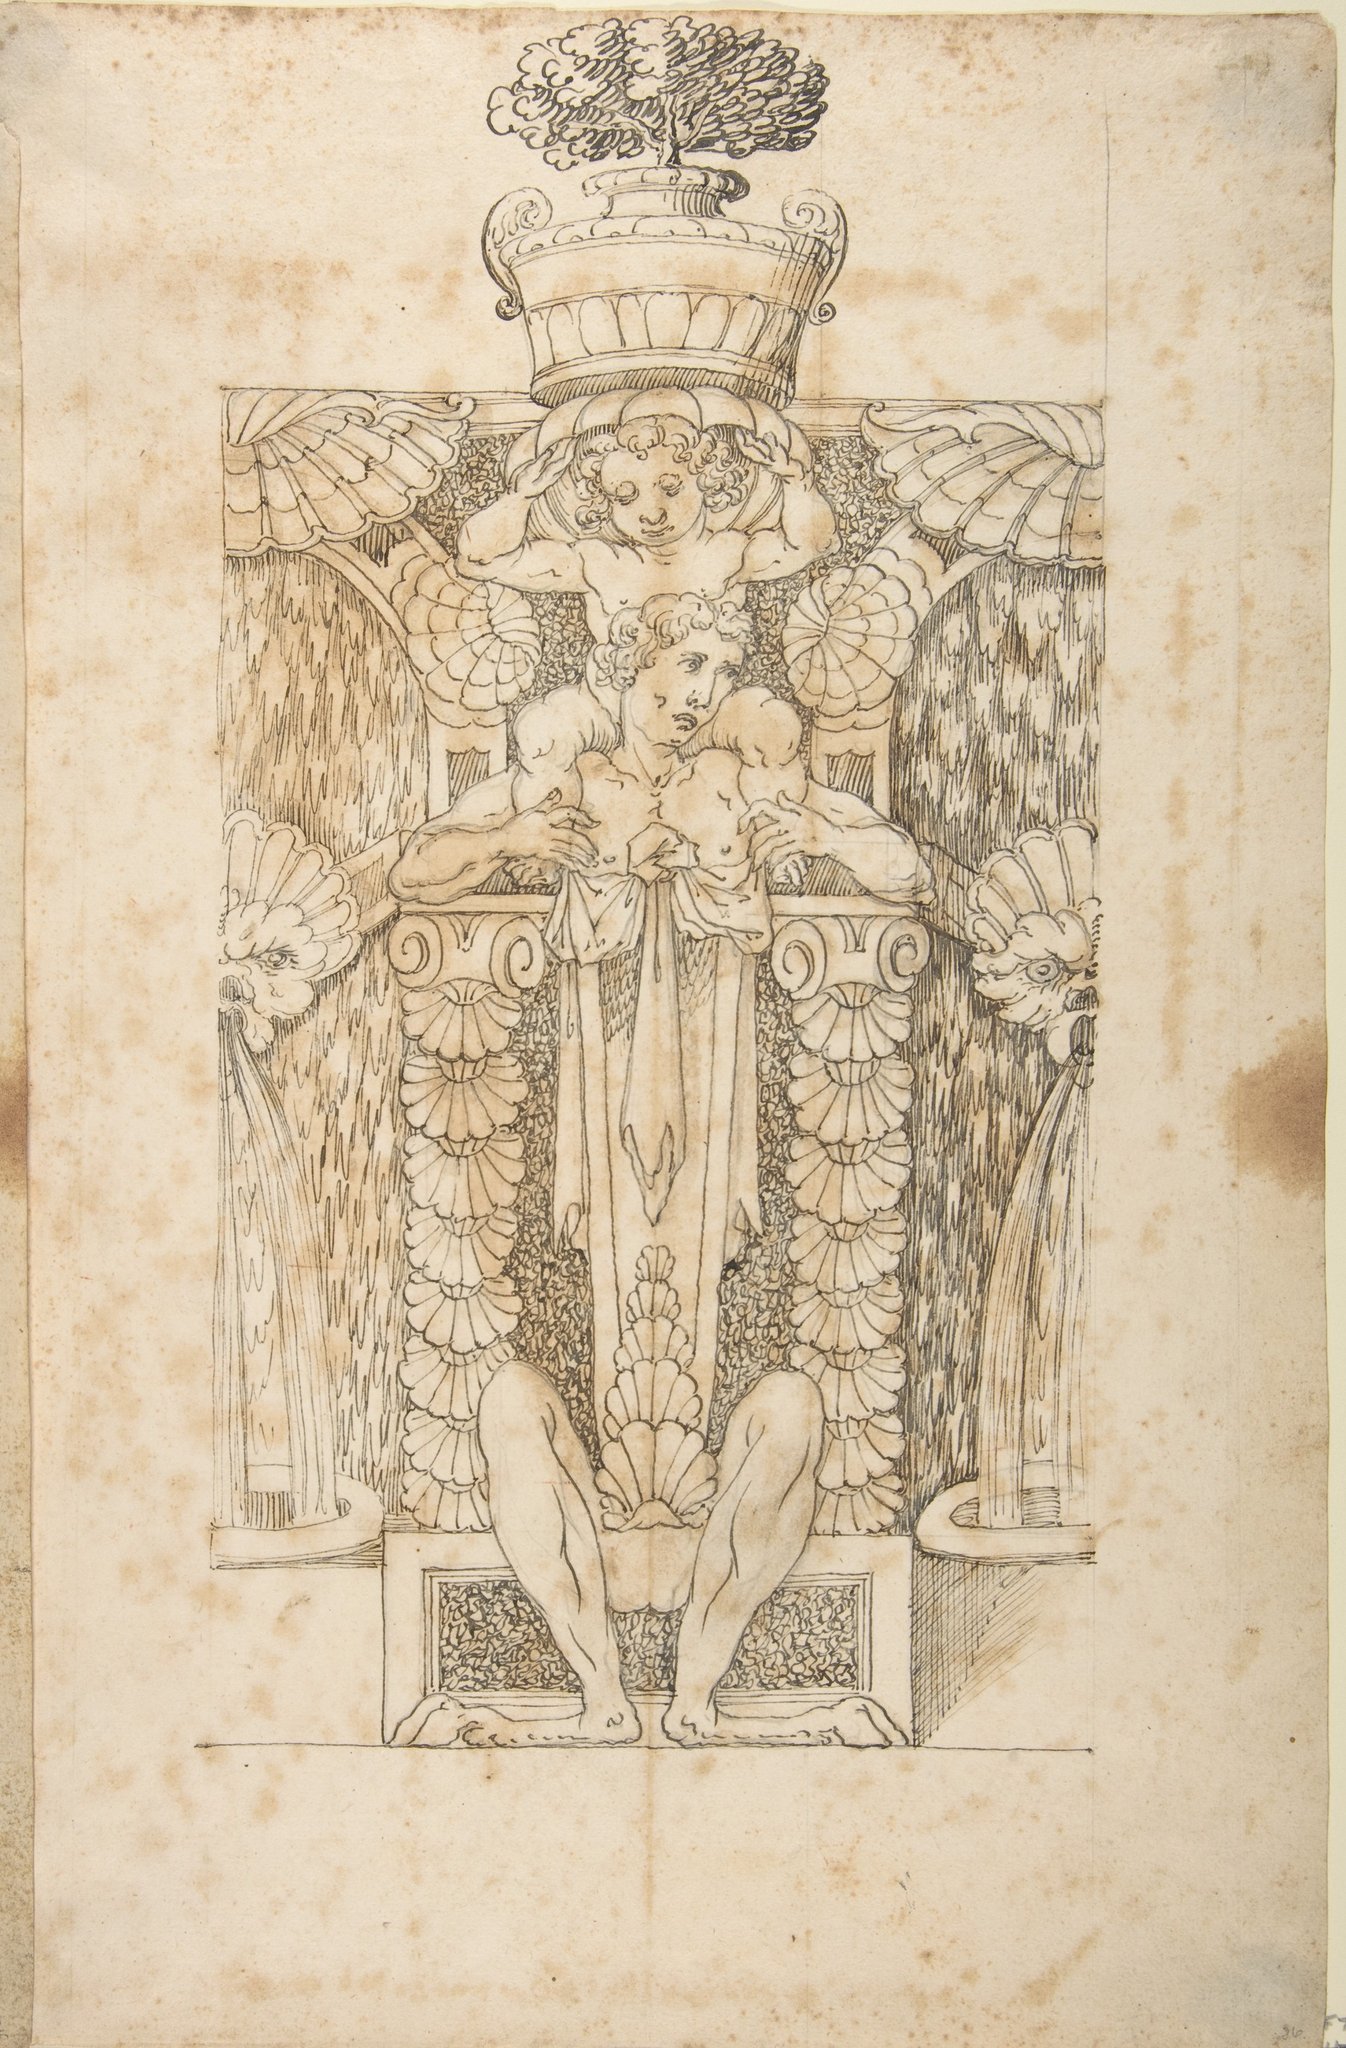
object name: drawing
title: Design for a Wall Fountain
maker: anonymous, italian, lombard, 16th century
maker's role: artist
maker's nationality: italian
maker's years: 1500-1600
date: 1550-1620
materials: graphite, ink, lead, drawing material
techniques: pen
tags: human figures,fountains,palmettes